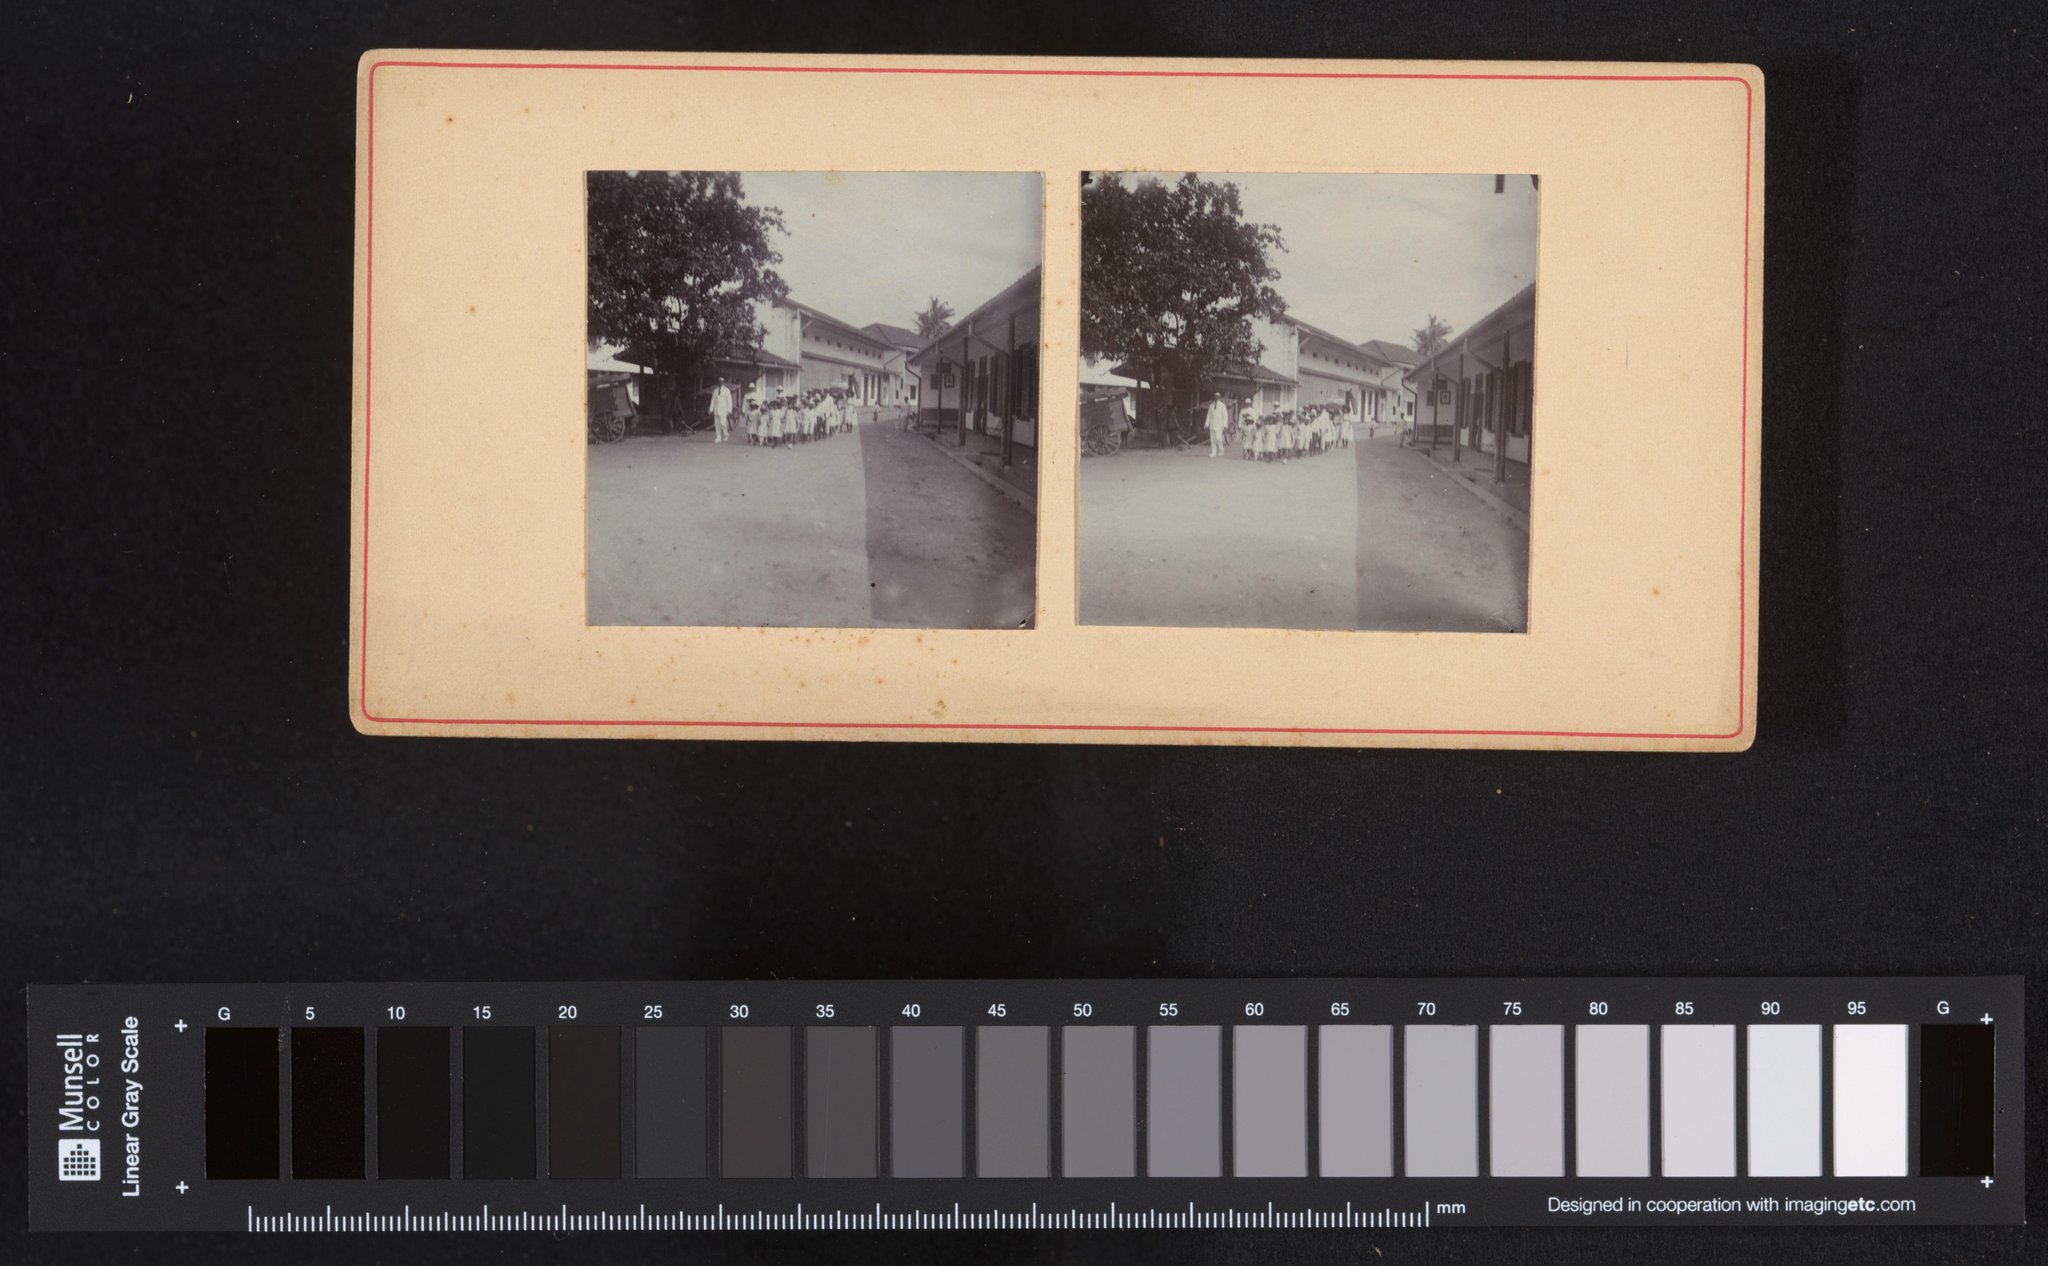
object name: stereograph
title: Schoolkinderen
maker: robert julius boers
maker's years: 1867-1932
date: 1900-1922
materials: cardboard, photographic support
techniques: gelatin silver print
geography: bangka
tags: robert julius boers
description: Een groep schoolkinderen met onderwijzers lopend over straat, waarschijnlijk te Banka. Onderdeel van een groep stereofoto's van Robert Julius Boers, chef van het staatsbedrijf de Banka-tinwinning op Banka, uit de periode ca. 1900-1922.